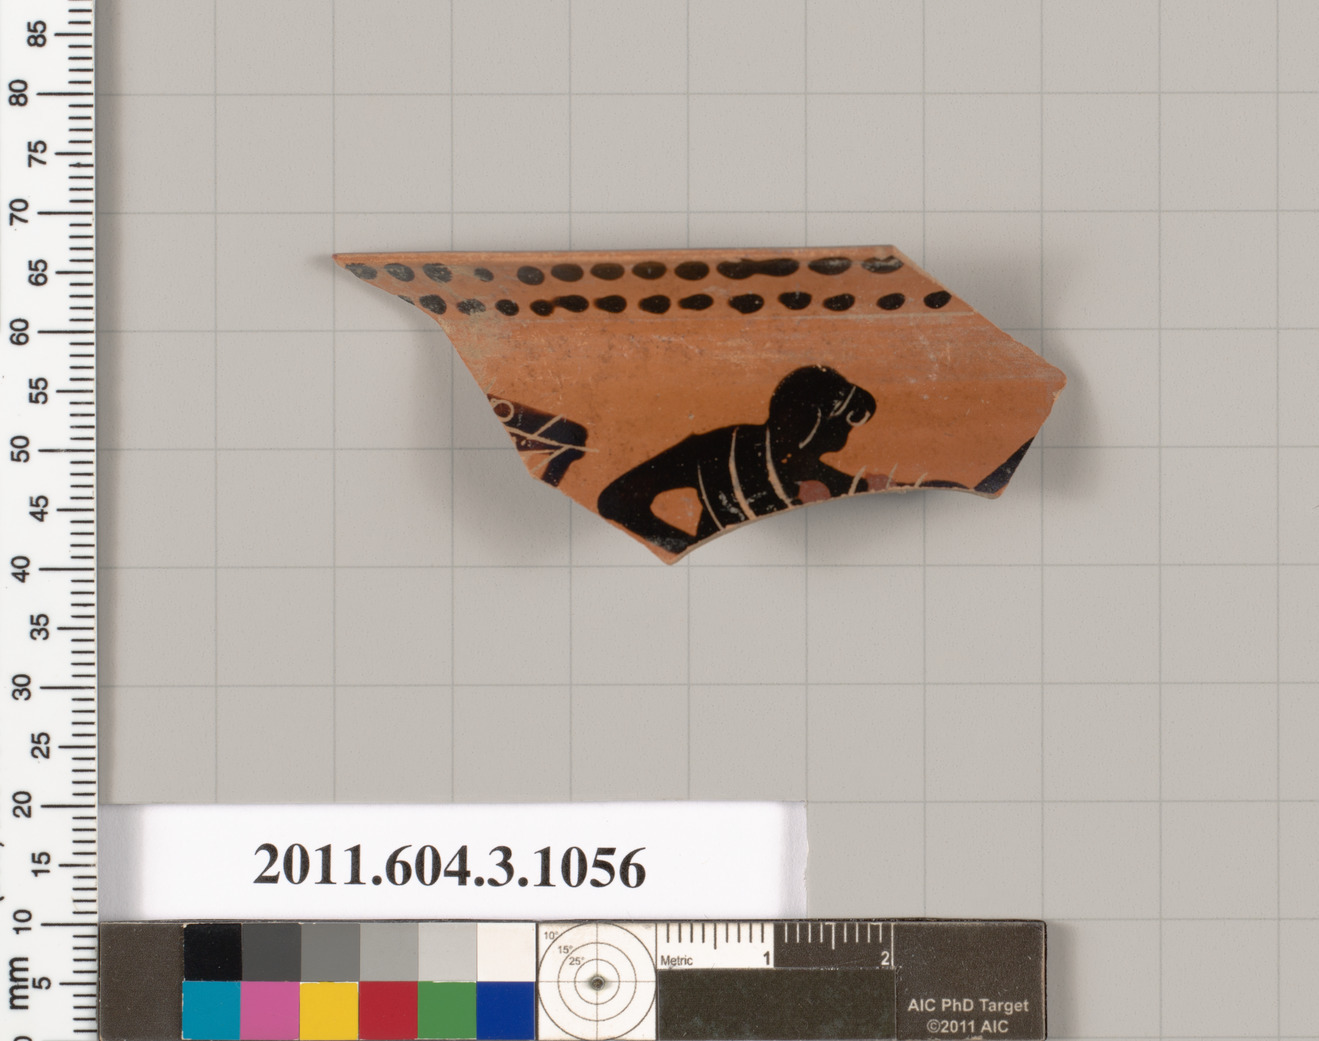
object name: mastoid fragment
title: Terracotta fragment of a mastoid (drinking cup with narrow base)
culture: greek, attic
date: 534-468 BCE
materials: terracotta